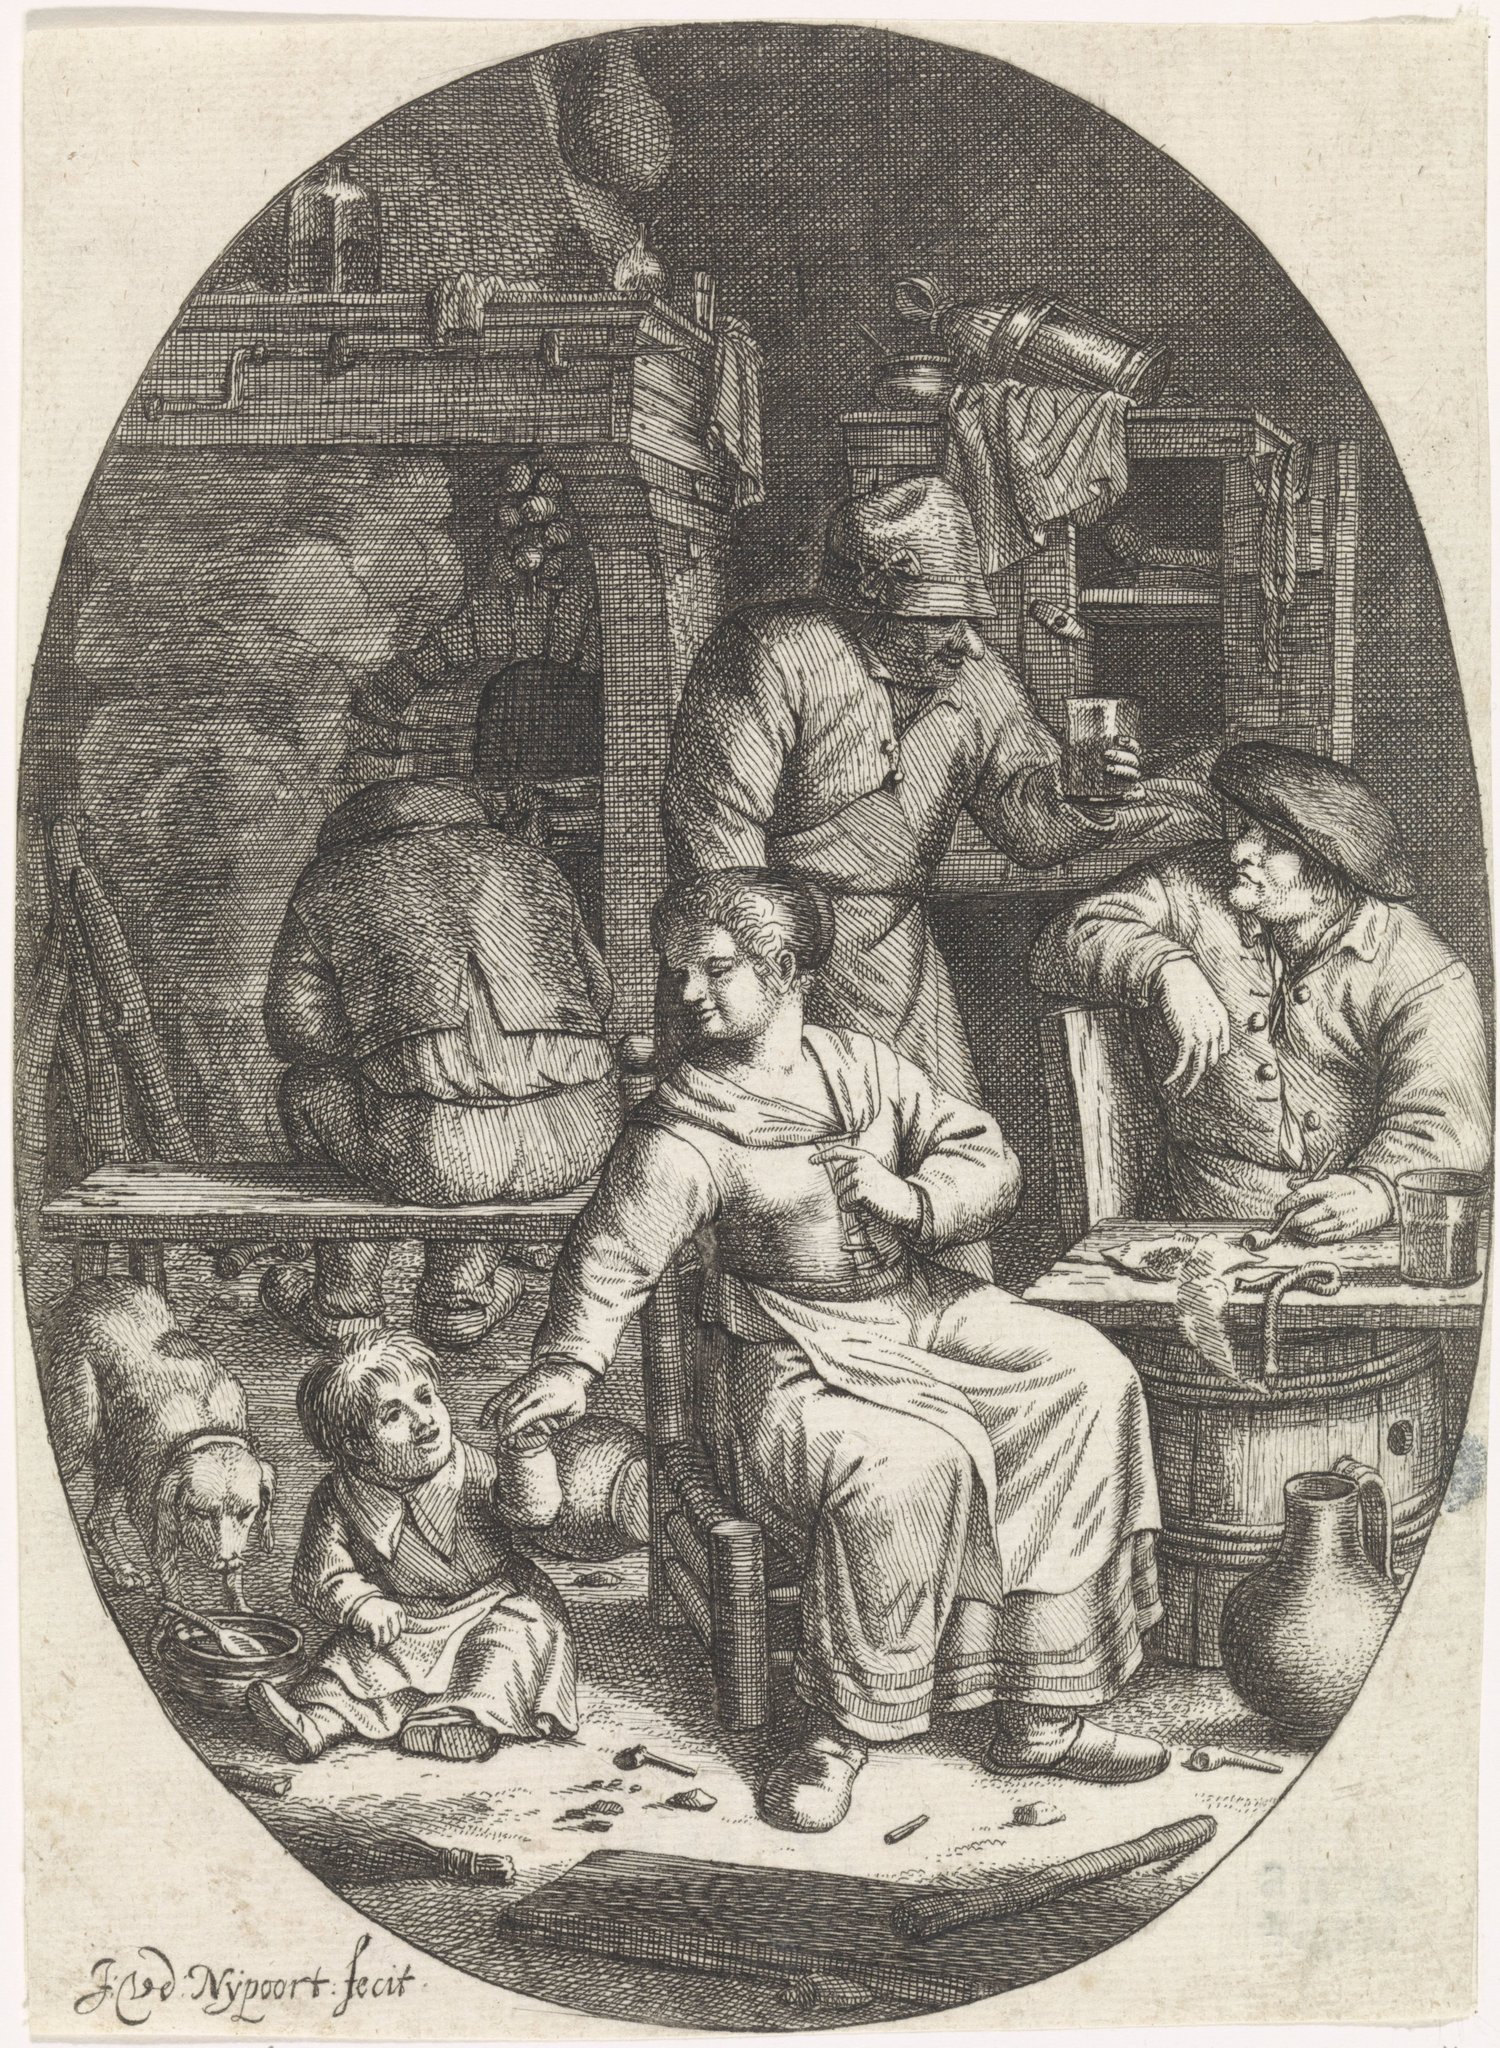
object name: print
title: Interieur van een boerenwoning met vijf figuren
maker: justus van den nijpoort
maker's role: draughtsman, print maker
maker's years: 1625-1692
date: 1635-1692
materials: paper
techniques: engraving, etching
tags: child, pipe ~ tobacco, open hearth, fire-place, farmers, farm (building) - aa - civic architecture: inside, dog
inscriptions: collector's mark: Lugt 2165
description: In een interieur zit een vrouw op een stoel, die de hand van een kind dat op de grond zit vastpakt. Naast het kind staat een hond bij het bord eten van het kind. Rechts zit een man met een pijp in zijn hand, die opkijkt naar een man met een bierglas. Een andere man zit, op de rug gezien, op een bank bij de haard.